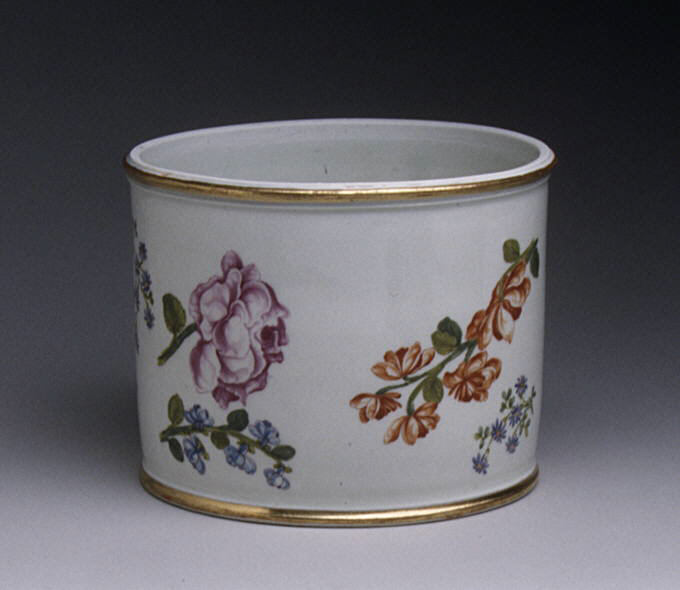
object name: container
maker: vienna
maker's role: manufactory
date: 1735-1740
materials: hard paste porcelain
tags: flowers